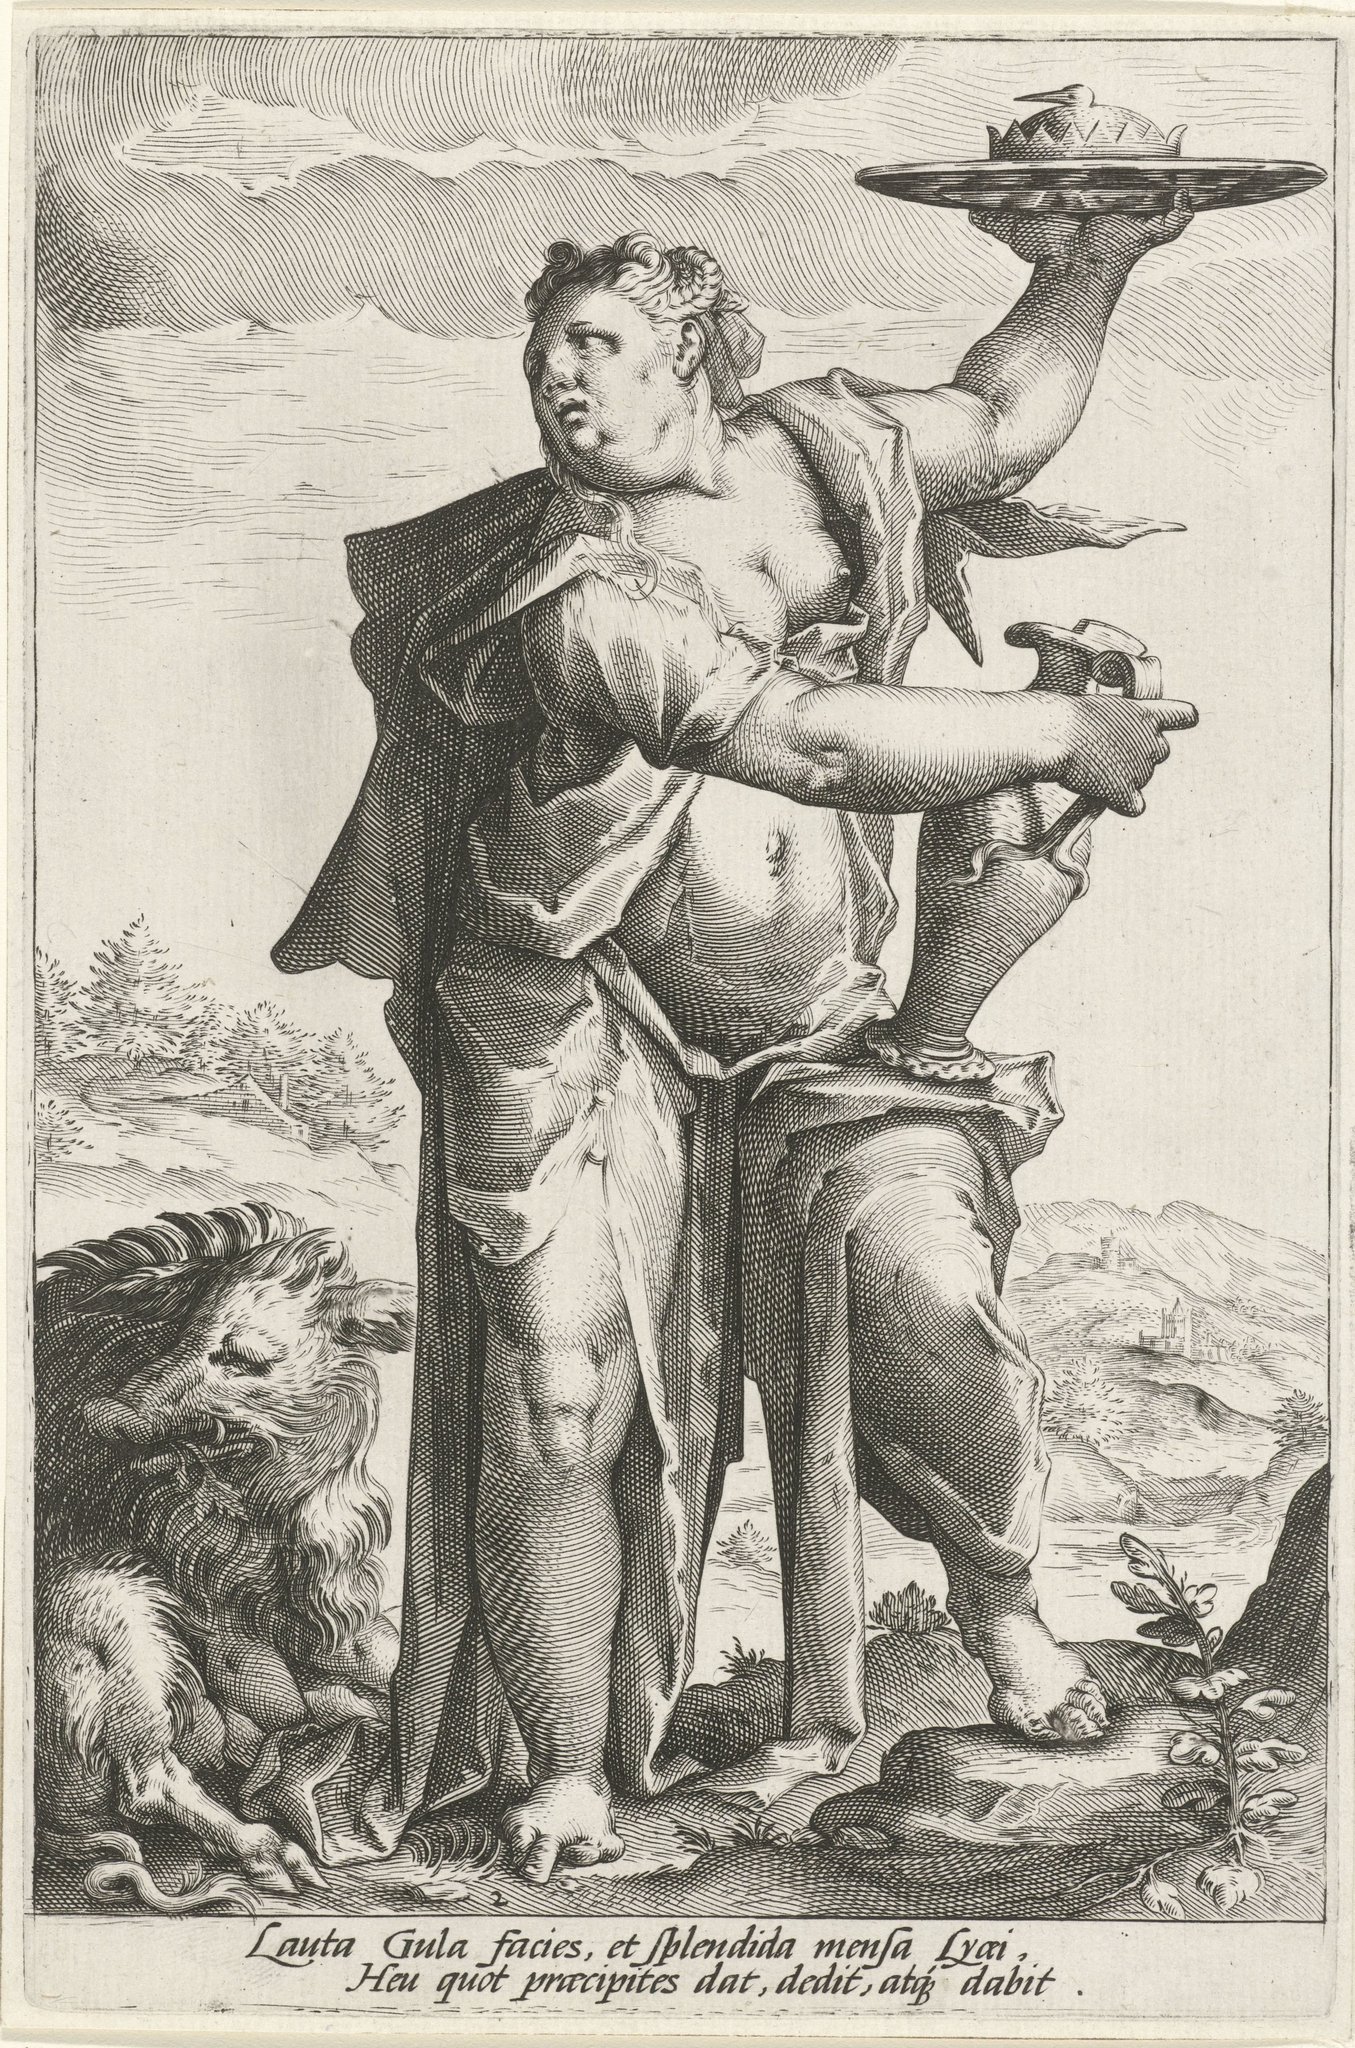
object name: print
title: De zonden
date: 1585-1589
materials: paper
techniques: engraving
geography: haarlem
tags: gluttony, intemperance, 'gula'; 'gola', 'ingordigia', 'ingordigia overo avidità', 'voracità' (ripa) ~ personification of one of the seven deadly sins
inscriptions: collector's mark: Lugt 240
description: De gepersonifieerde Gulzigheid; een dik vrouwenfiguur met in de ene hand een schaal met een pastei en in de andere hand een kruik, staande naast een wild zwijn.